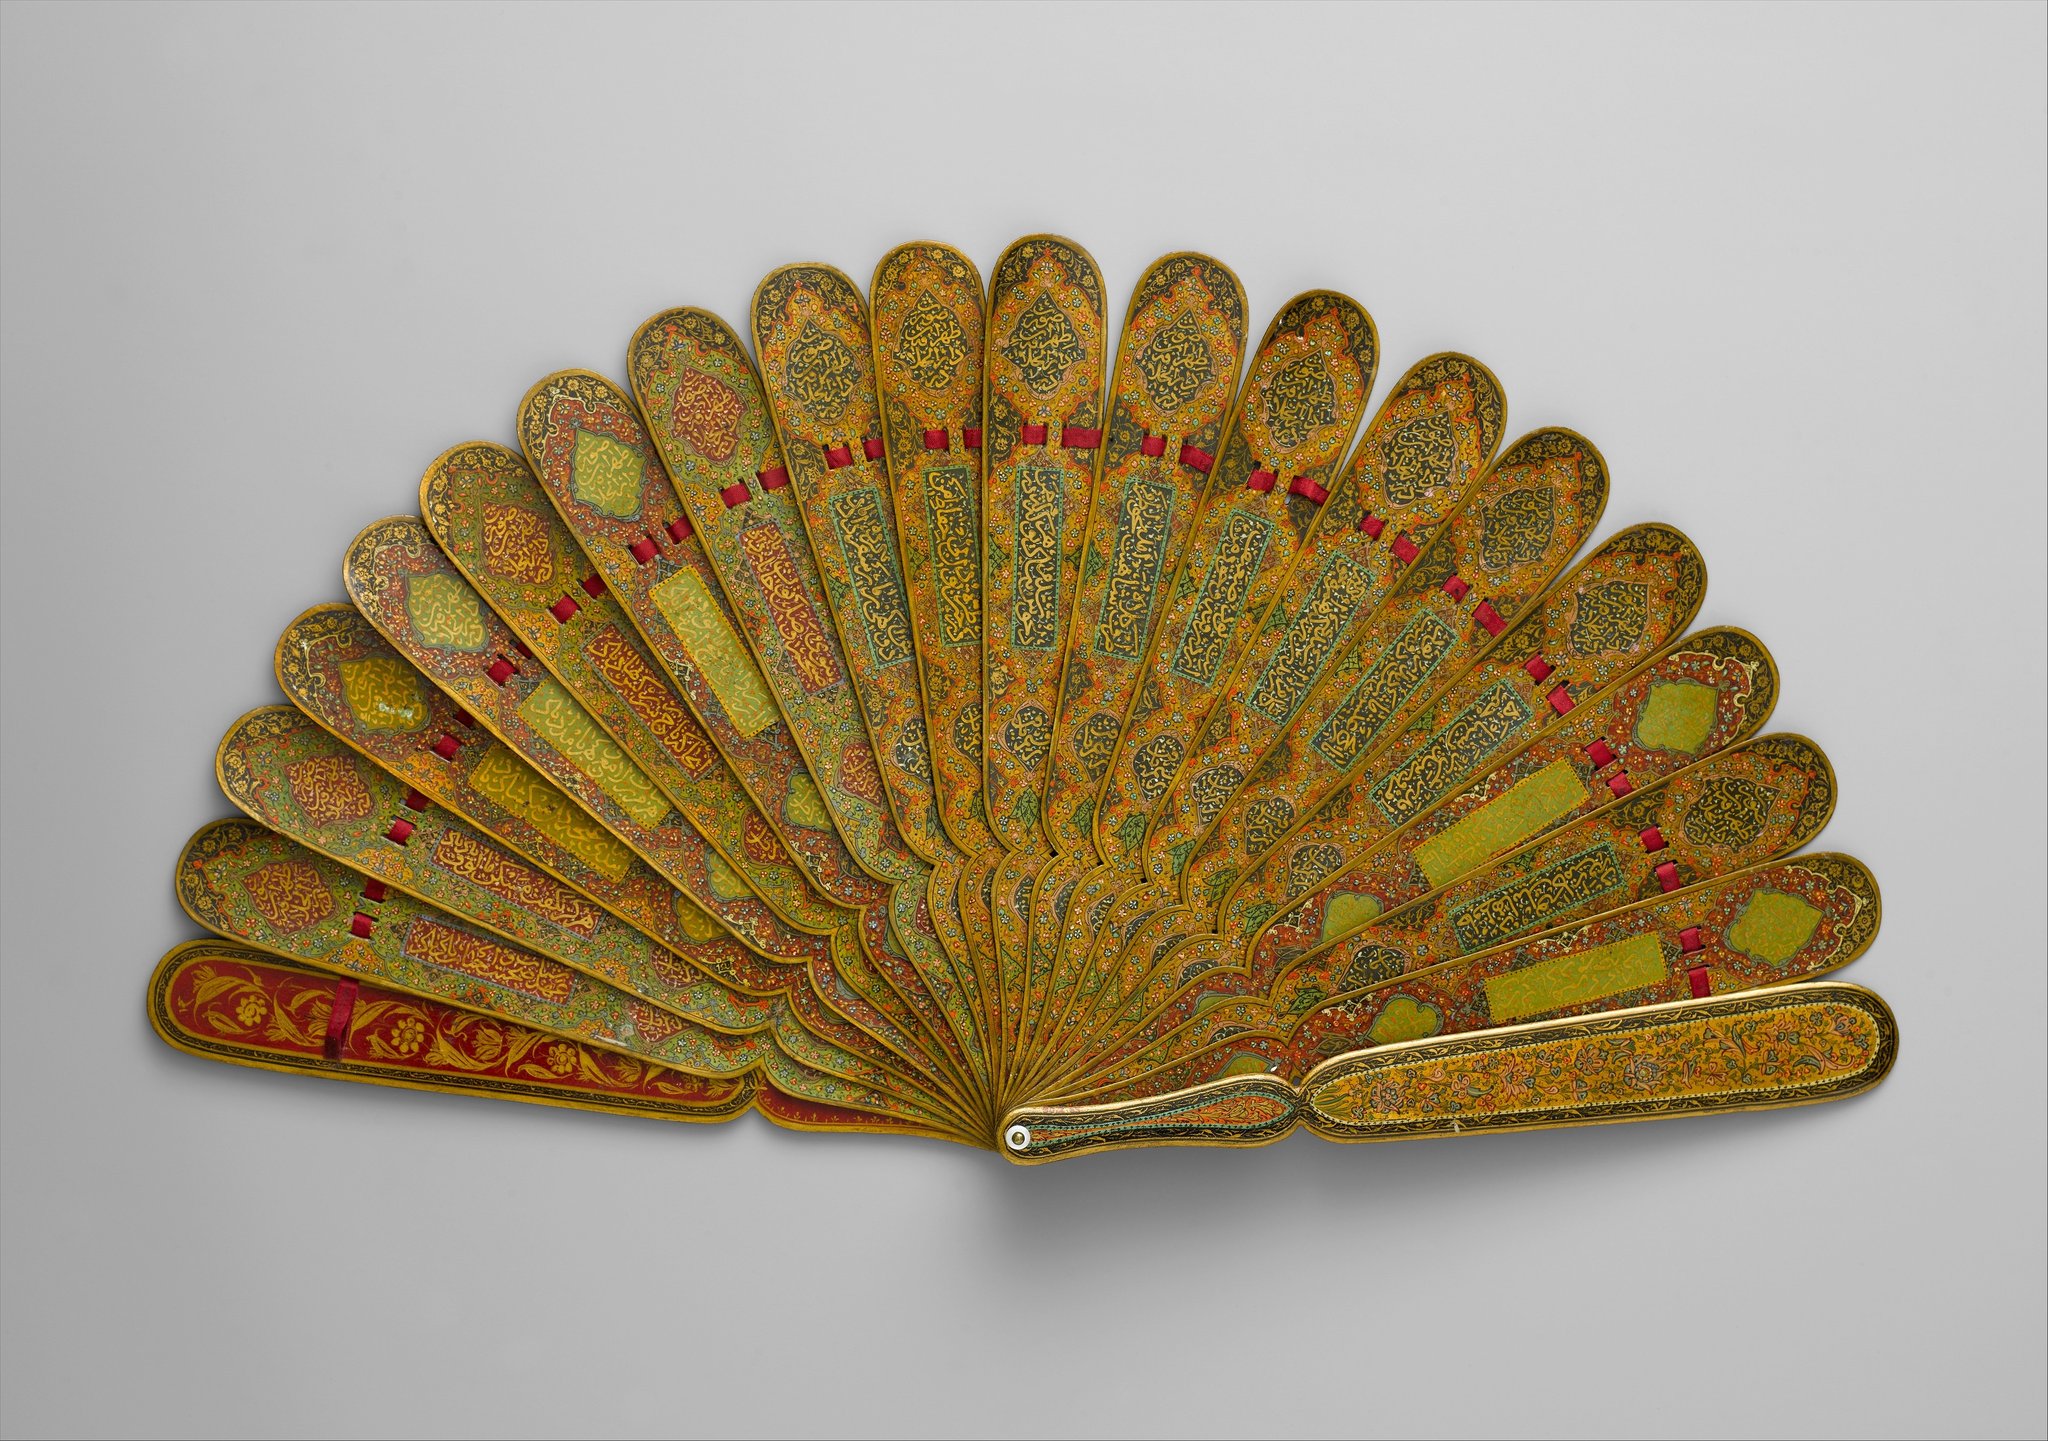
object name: fan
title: Fan with Poetic Verses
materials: wood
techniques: gilding, lacquer, painting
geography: iran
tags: poetry